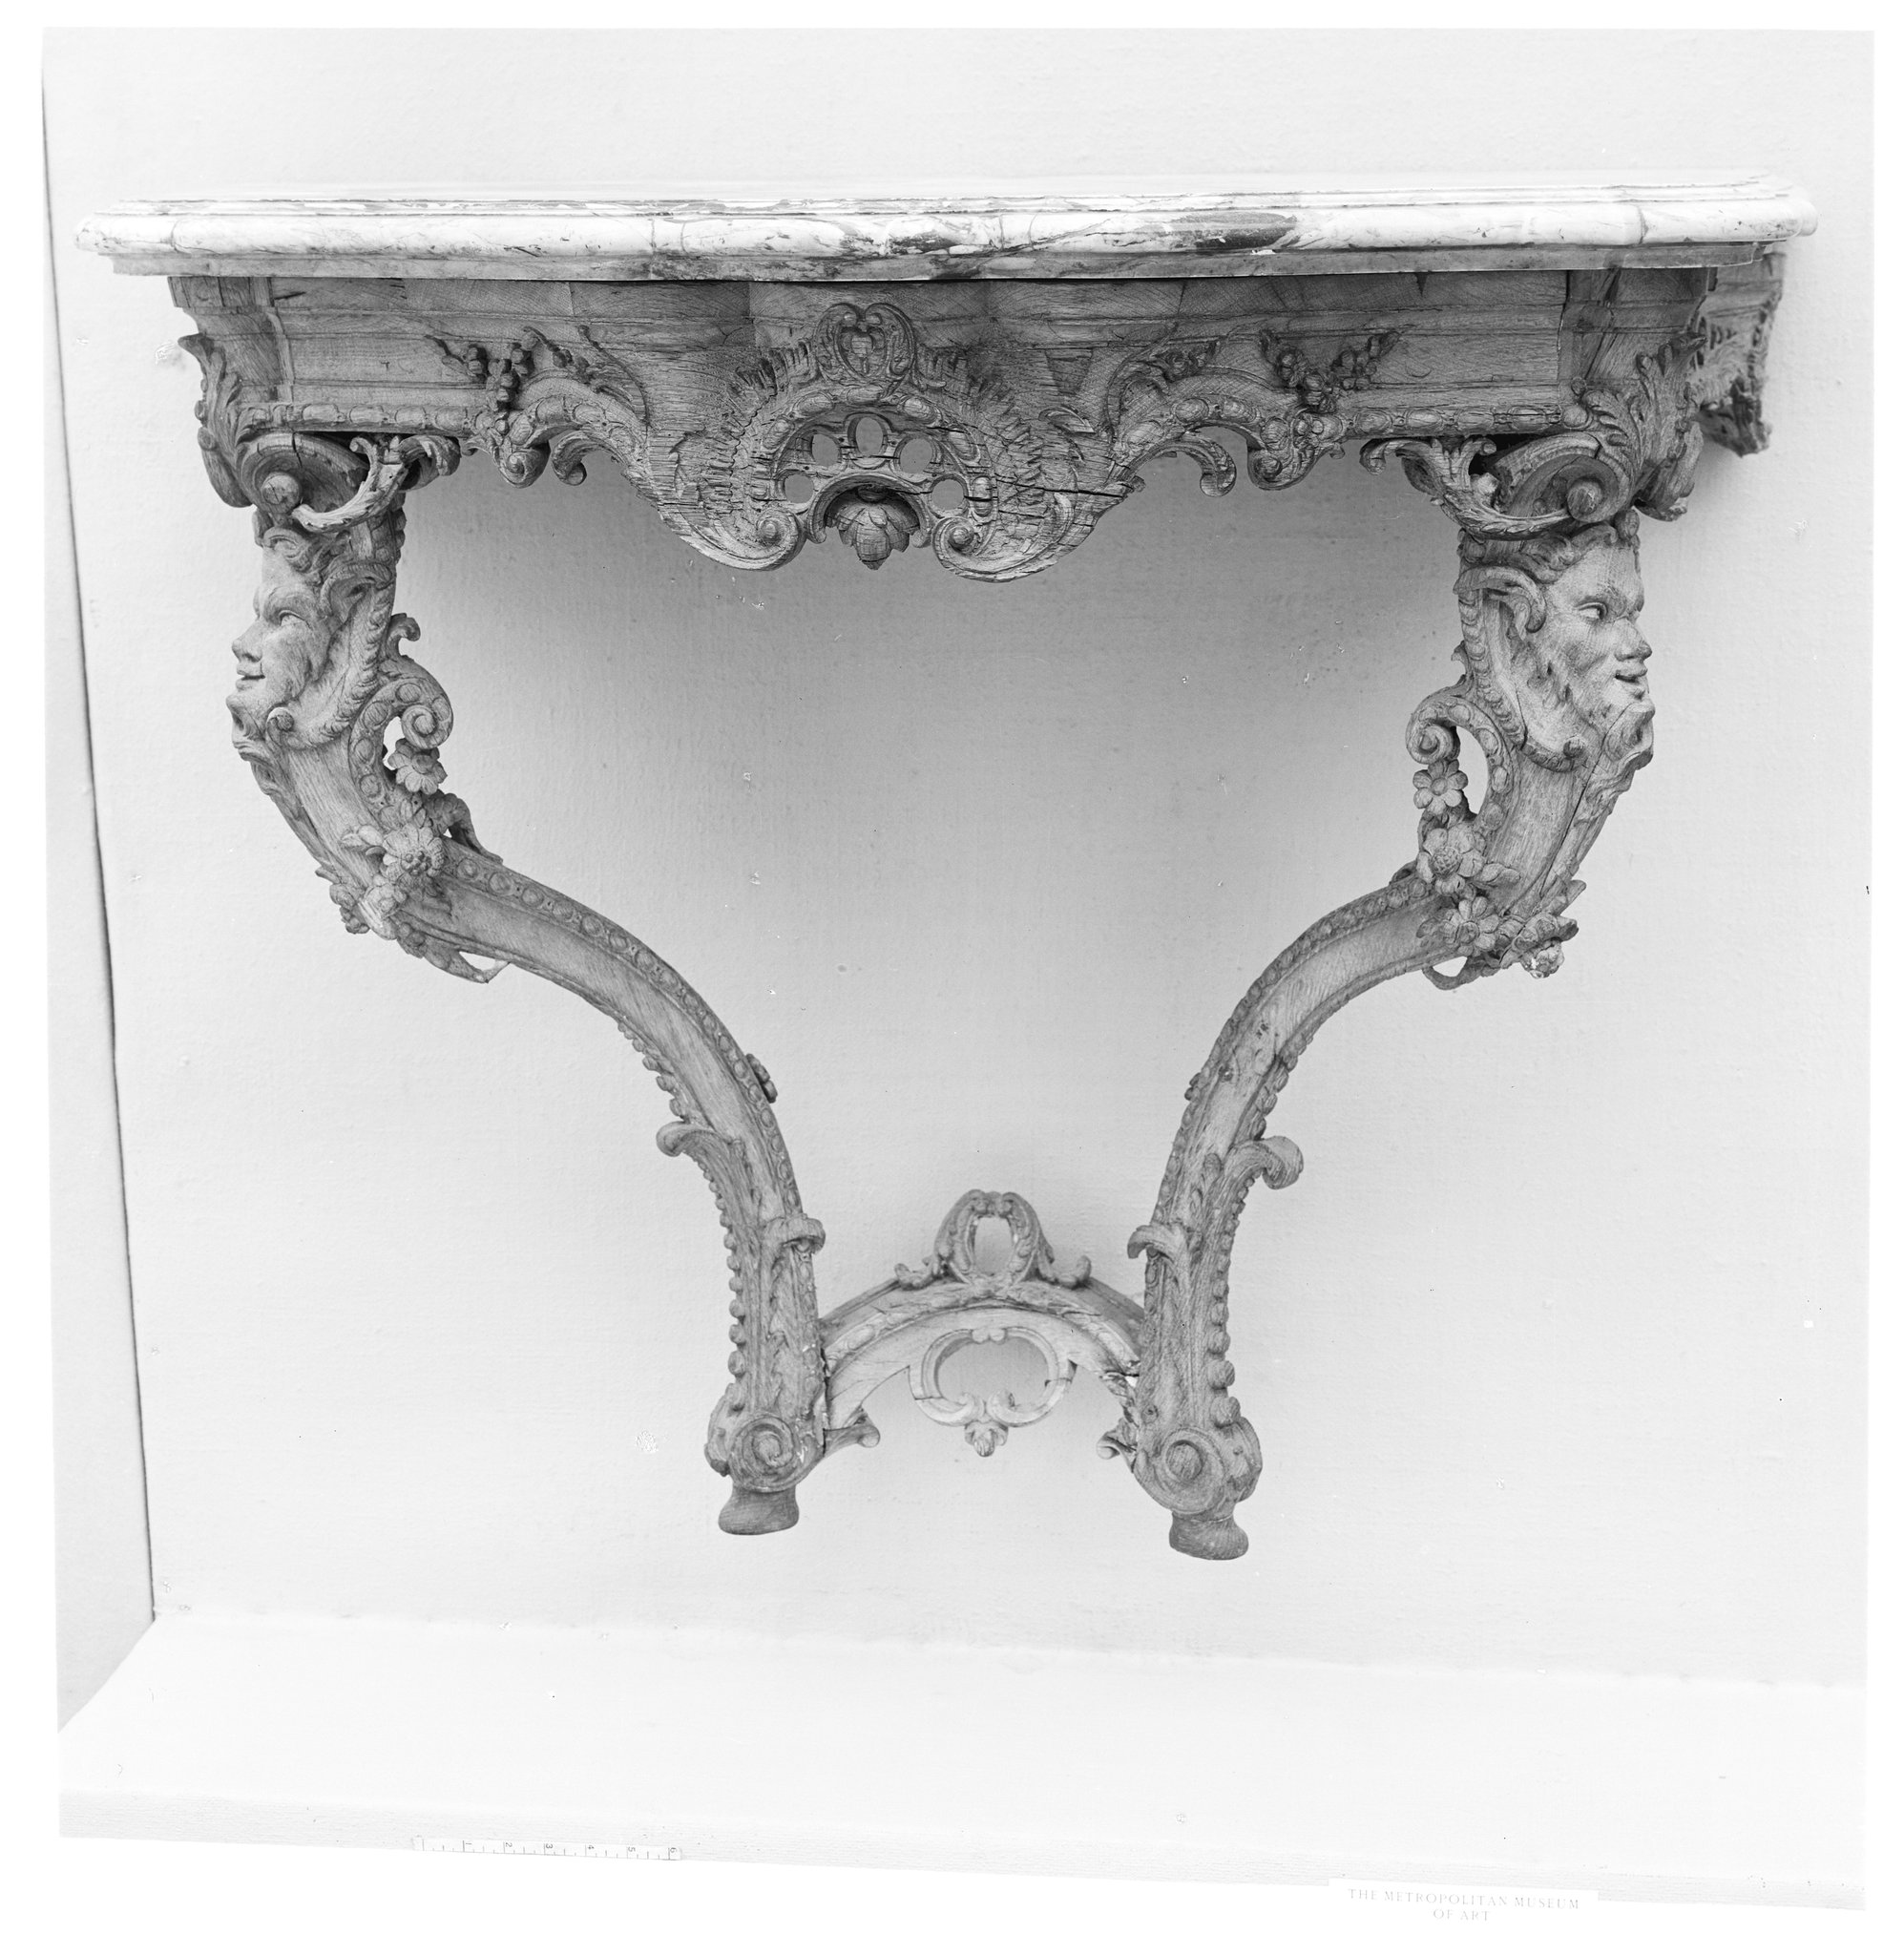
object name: console table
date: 1701-1725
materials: marble, wood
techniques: carving, gilding